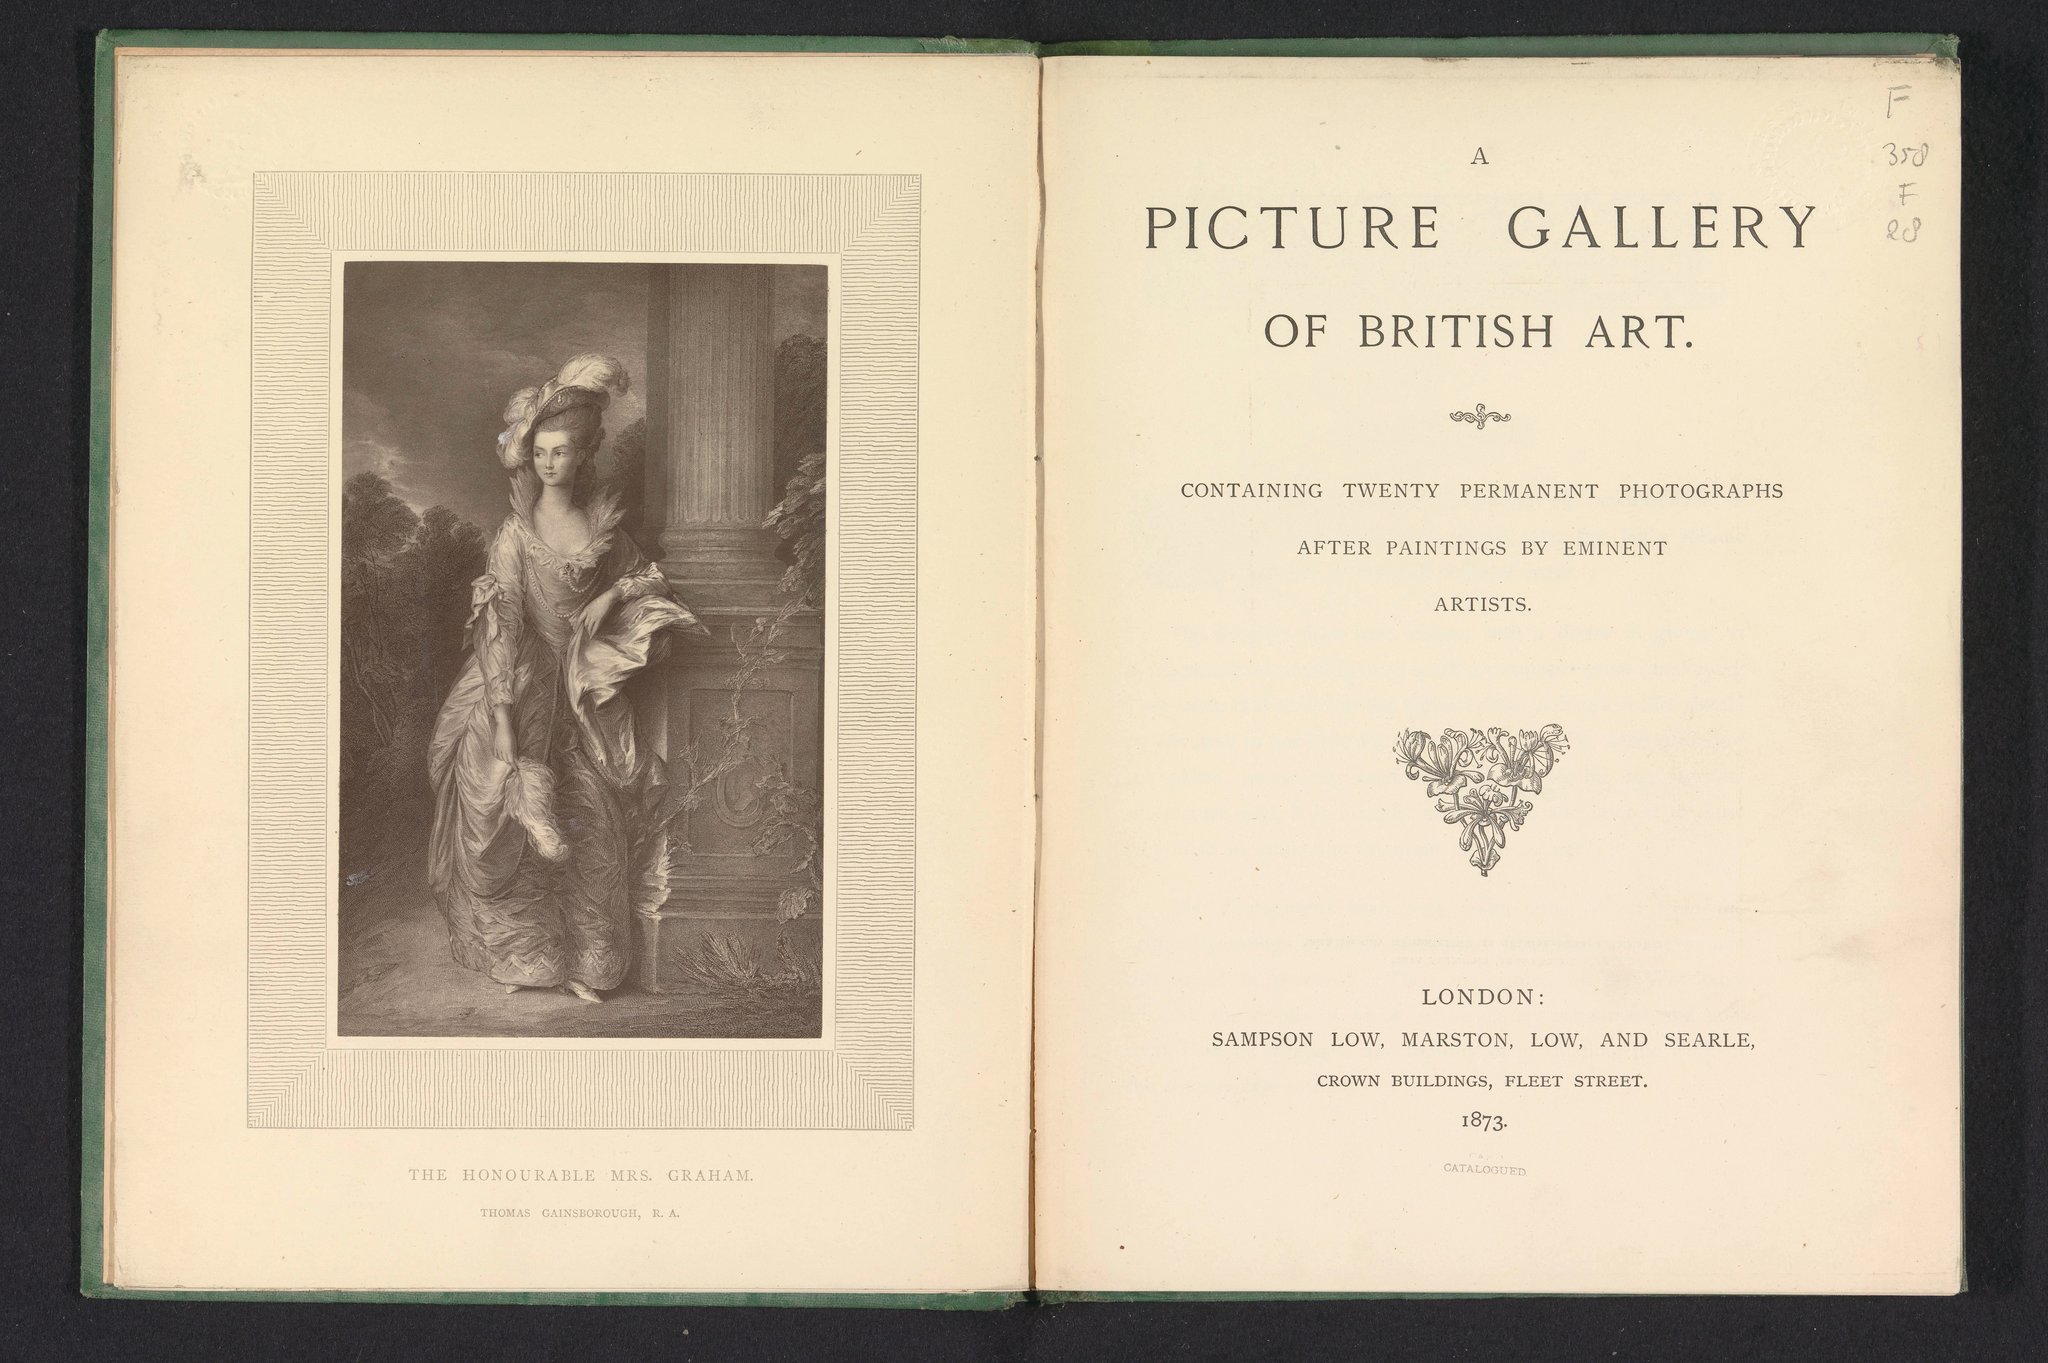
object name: book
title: A picture gallery of British art containing twenty permanent photographs after paintings by eminent artists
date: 1873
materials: cardboard, linen, paper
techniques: woodburytype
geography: london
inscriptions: name: ‘Essex Institute Art Library (...)’, name: ‘A.A Smith & Co., Salem Mass.’